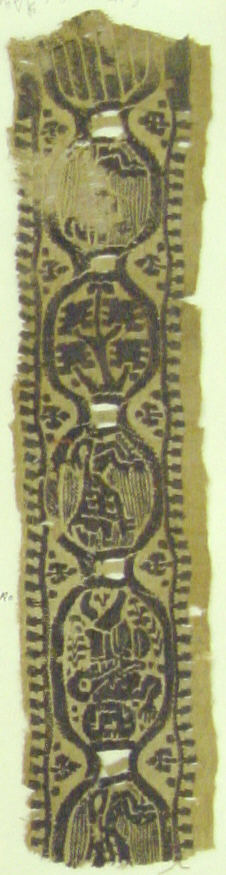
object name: textile fragment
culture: coptic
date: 501-600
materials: linen, wool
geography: egypt